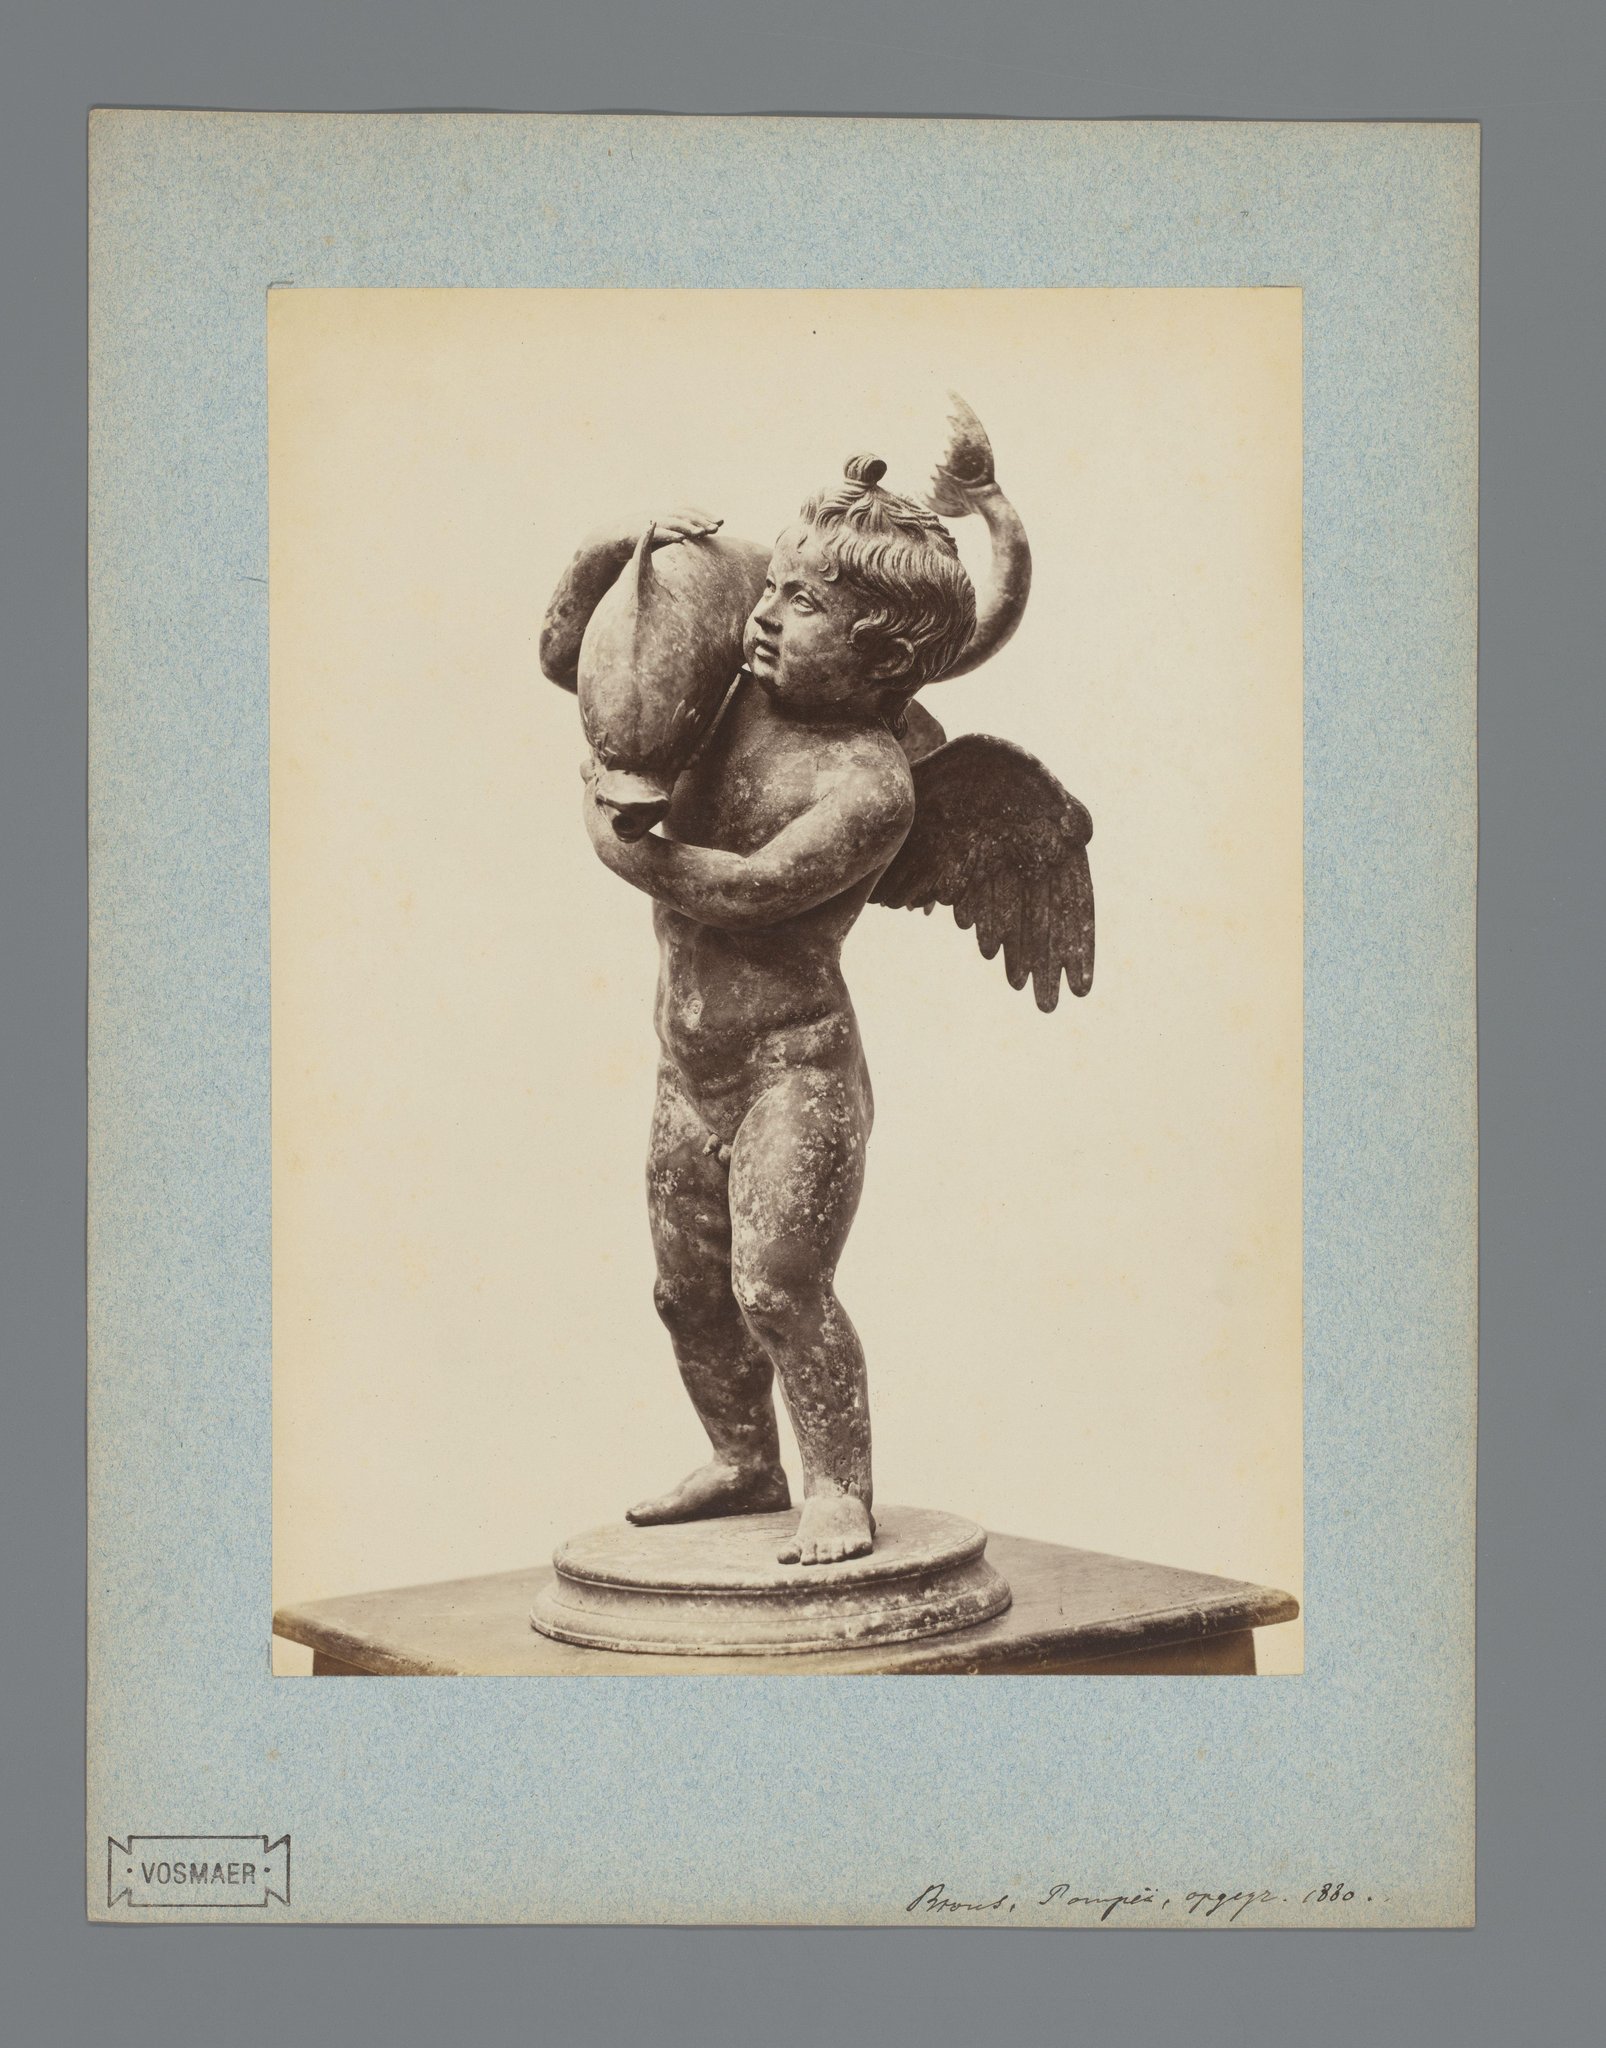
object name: photograph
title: Bronzen sculptuur, opgegraven in Pompeï, Italië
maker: Anonymous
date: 1880-1890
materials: cardboard, paper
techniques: albumen print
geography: italy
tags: sculpture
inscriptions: inscription: ‘Brons, Pompeii, opgegr. 1880.’, collector's mark: ‘VOSMAER’